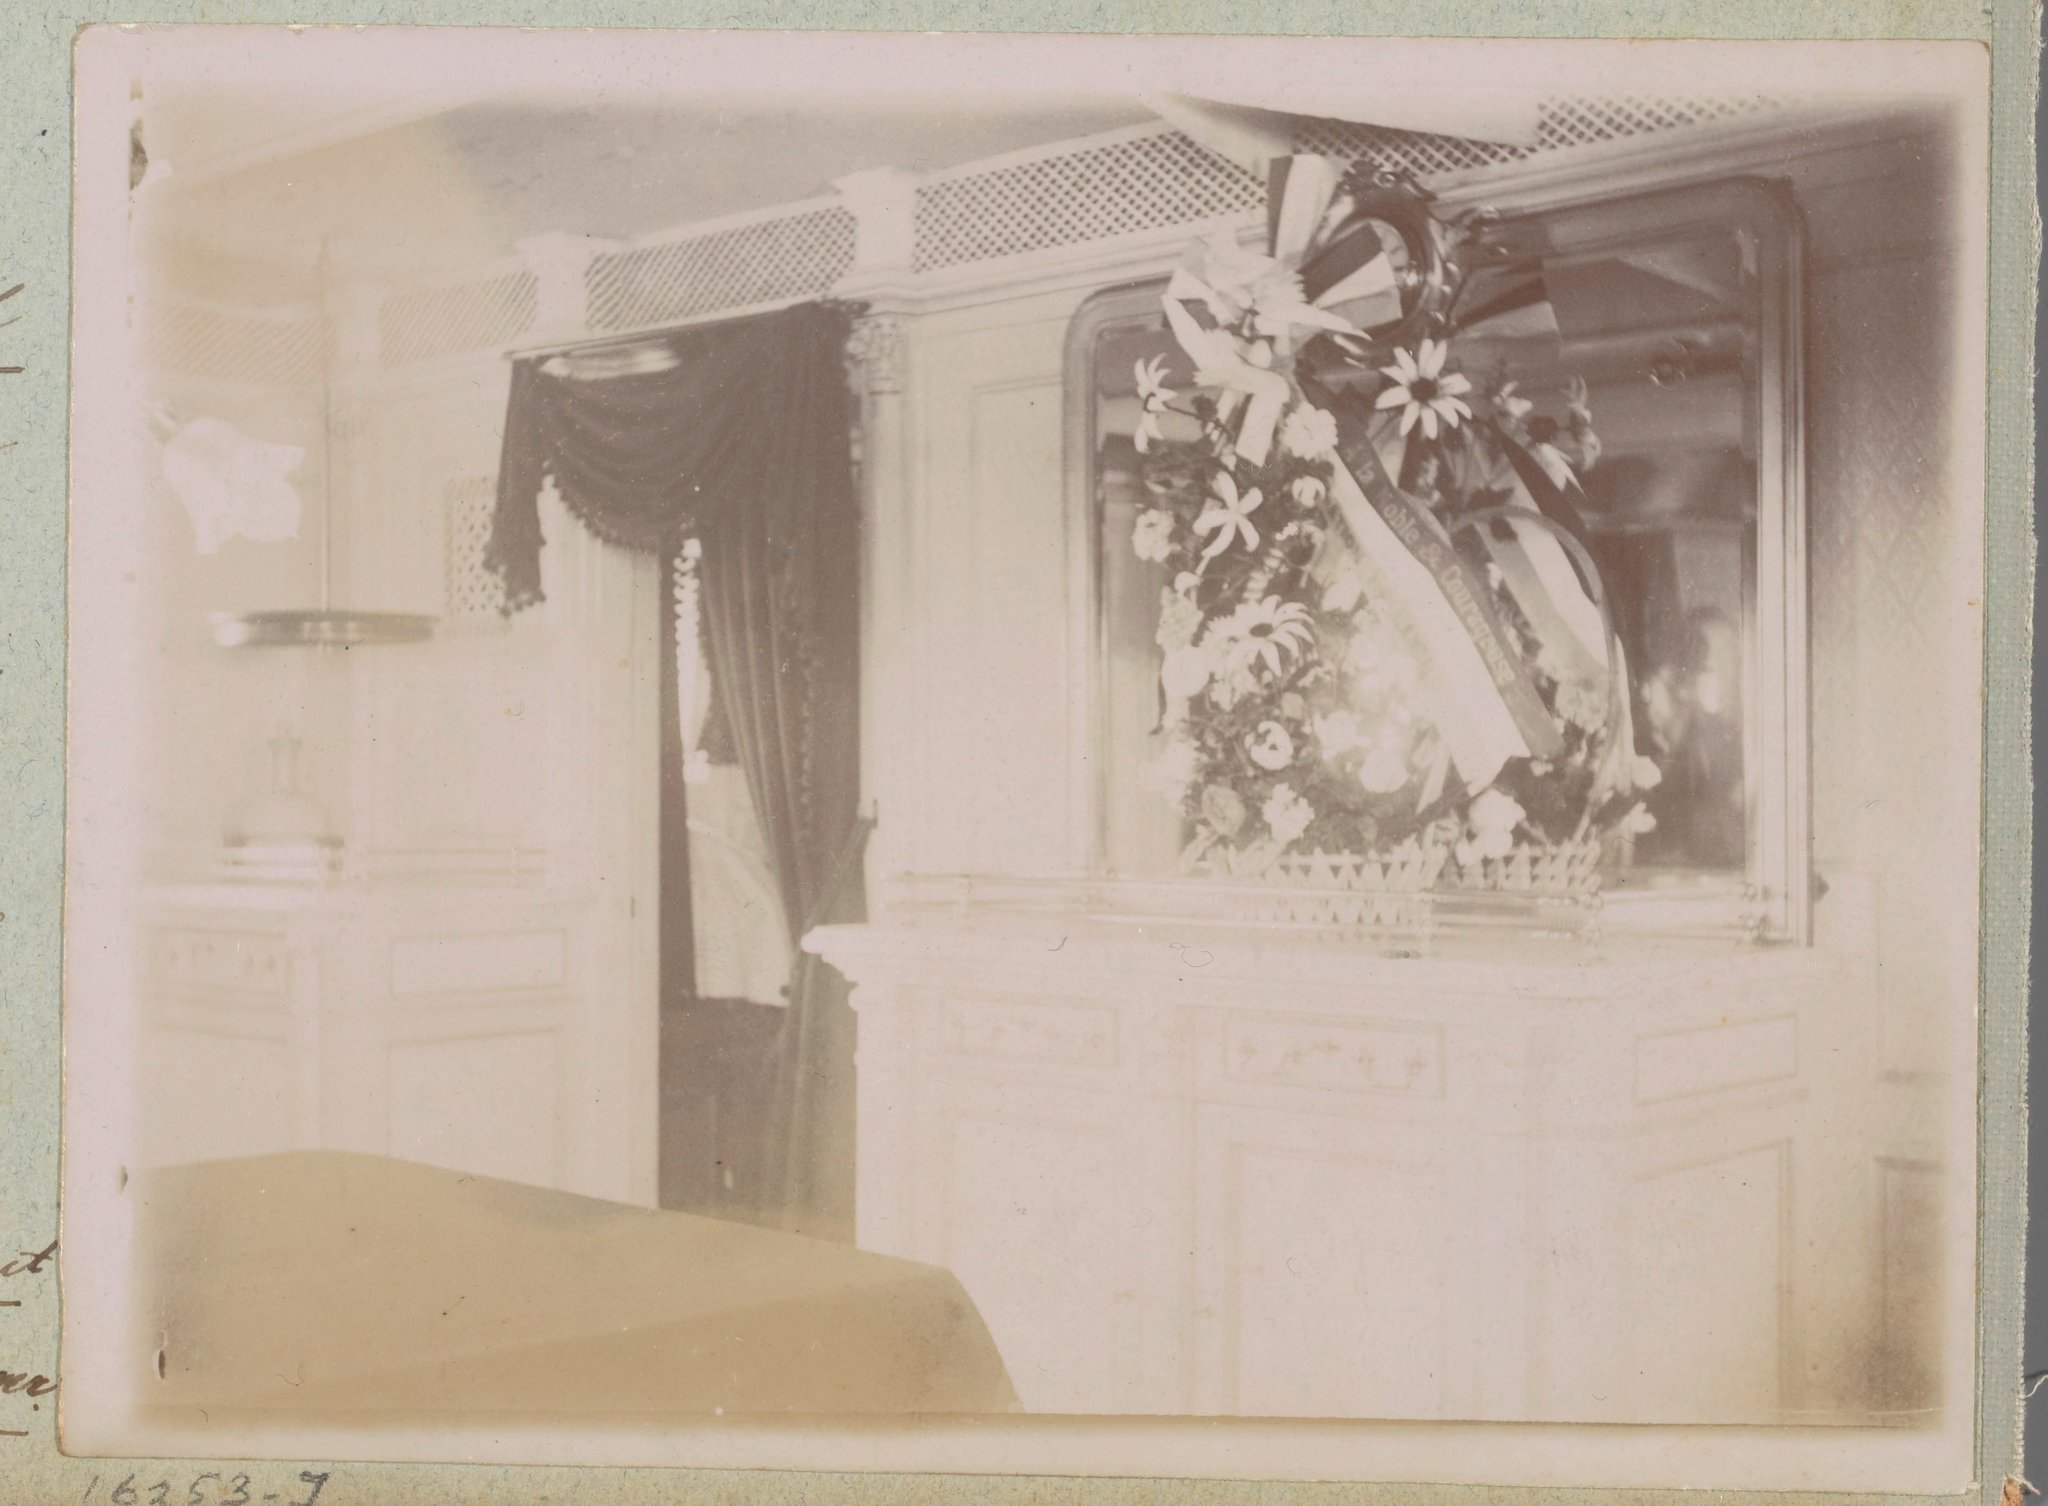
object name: photograph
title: Bloemenkrans met lint aan boord van de H.M. Gelderland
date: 1900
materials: paper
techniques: collodion silver print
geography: marseille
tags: flowers, parts of ship's interior, marseille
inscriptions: inscription: ‘Bloemstuk/ aangeboden/ aan H.M./ Gelderland/ te/ Marseille/ 1900/ na de reis met/ President Kruger.’